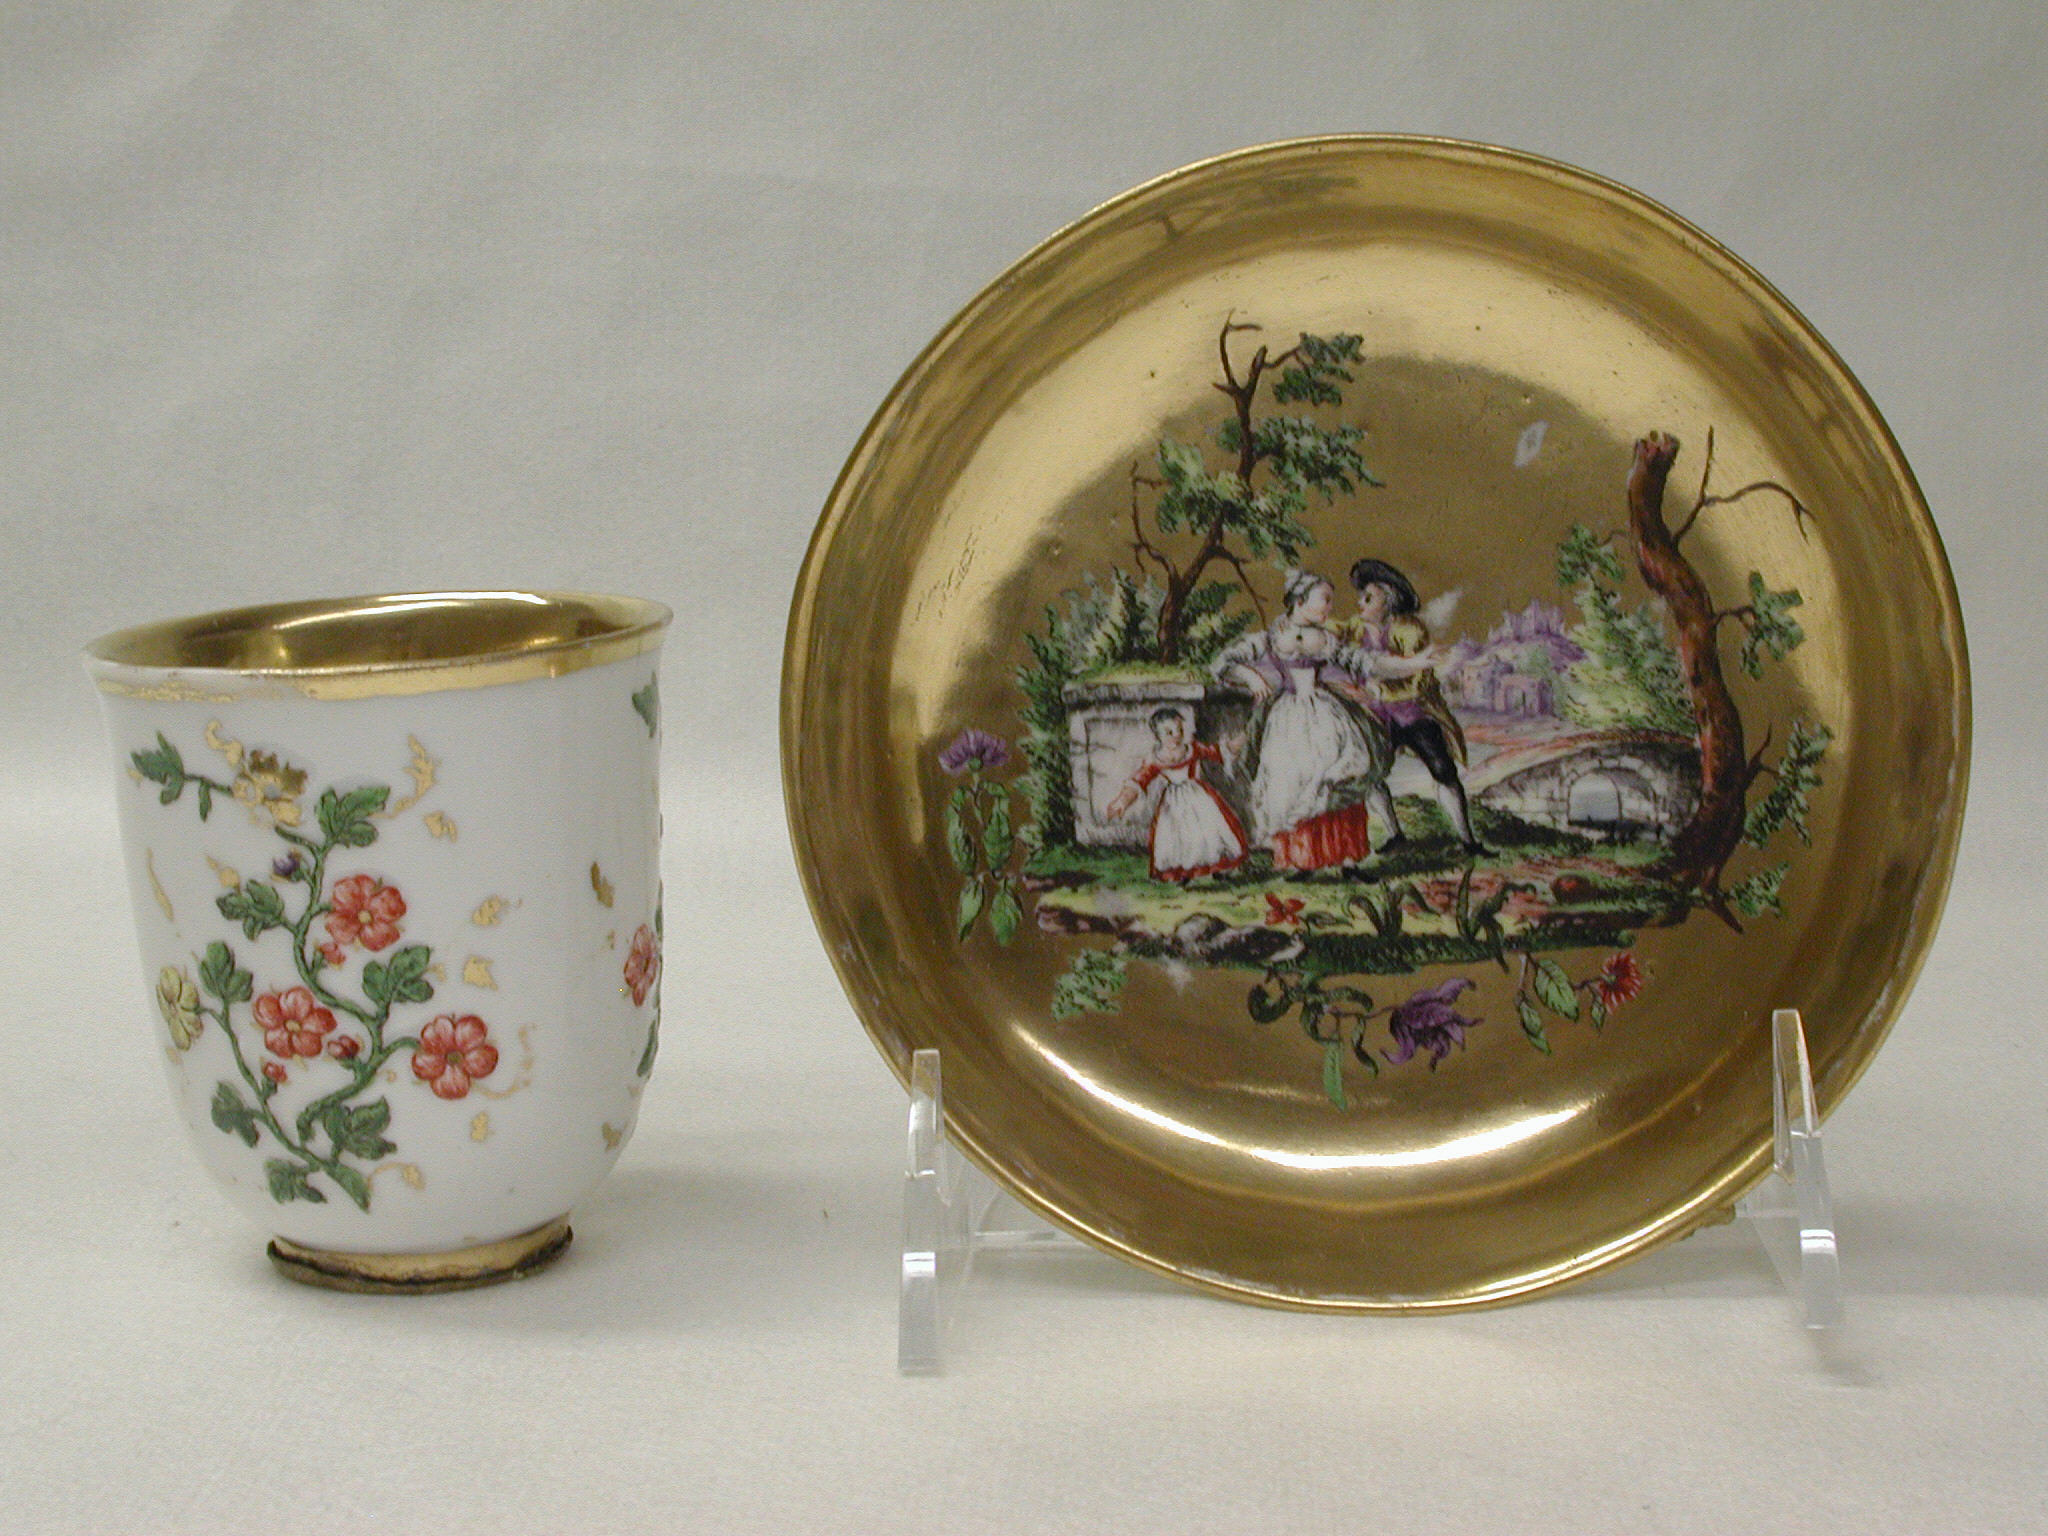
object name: saucer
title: Saucer (part of a service)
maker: nymphenburg porcelain manufactory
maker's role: manufactory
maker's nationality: german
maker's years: 1747-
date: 1760-1765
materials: hard paste porcelain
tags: girls,men,women,flowers